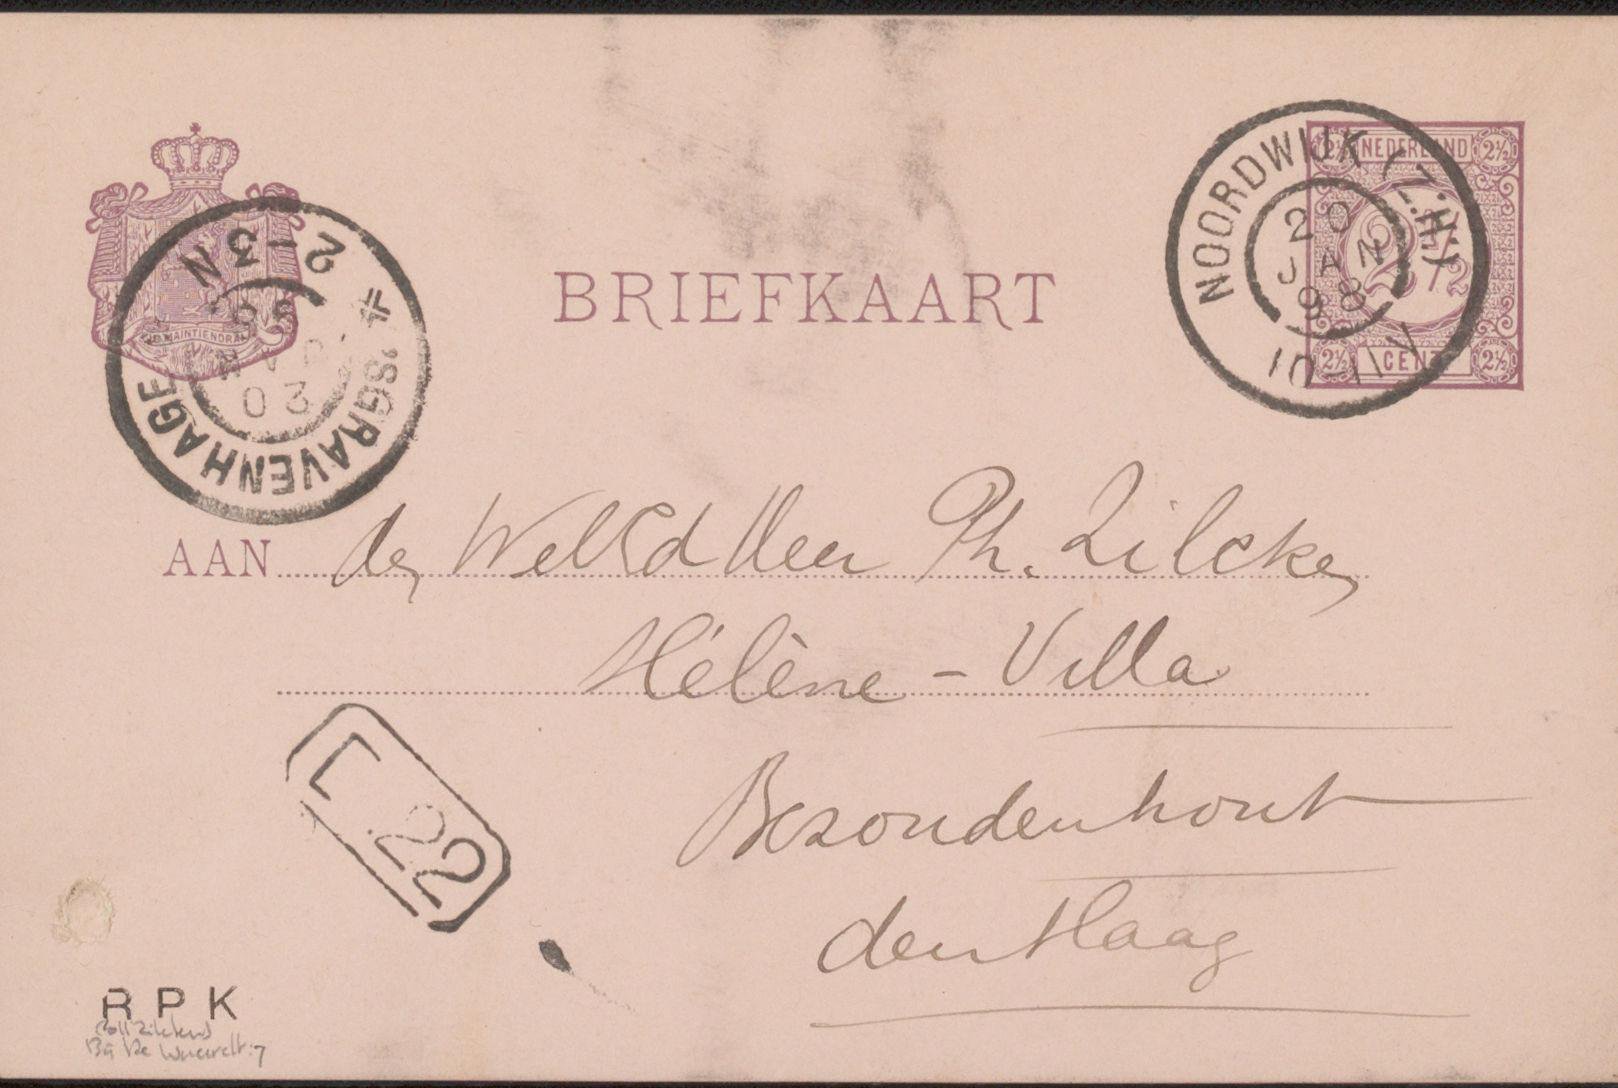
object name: postcard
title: Briefkaart aan Philip Zilcken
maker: jan de waardt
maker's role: draughtsman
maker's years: 1871-1909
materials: cardboard, ink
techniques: pen, writing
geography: noordwijk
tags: the hague, painter, draughtsman, philip zilcken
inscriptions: collector's mark: ‘RPK’